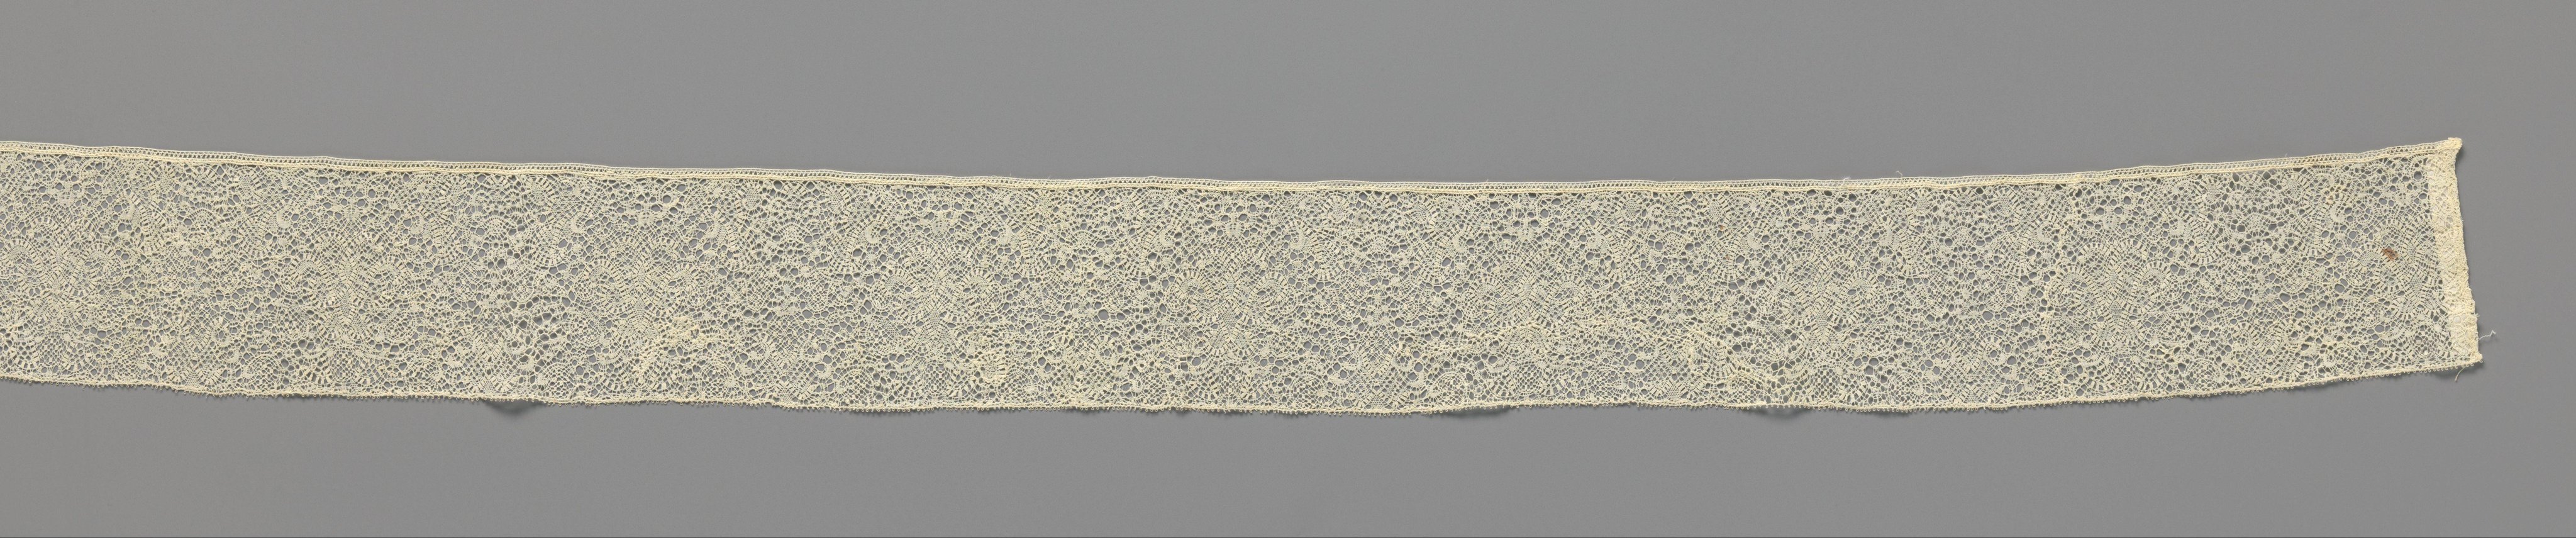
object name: strip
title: Strook kloskant met v-vormen gemaakt van smalle sierbandjes met rechthoekige vormslagen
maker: Anonymous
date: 1700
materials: linen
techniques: lace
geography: southern netherlands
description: Strook naturelkleurige kloskant, Binche-kant. Het zich herhalende patroon bestaat uit wirwar van kleine motiefjes gemaakt met verschillende siergronden. De omtrekken hiervan zijn gedeeltelijk benadrukt met smalle sierbandjes met rechthoekjes, gemaakt in vormslag. Op de middenlijn maken de sierbandjes op regelmatige afstand van elkaar een v-vorm, die door twee in elkaar hakende c-vormen wordt oversneden. De motieven zijn met elkaar verbonden door een onregelmatige siergrond, een sneeuwvlokkengrond. De boven- en onderzijde van de strook zijn recht afgewerkt, waarbij de onderzijde is voorzien van picots. De korte kanten zijn afgewerkt met een zoompje.